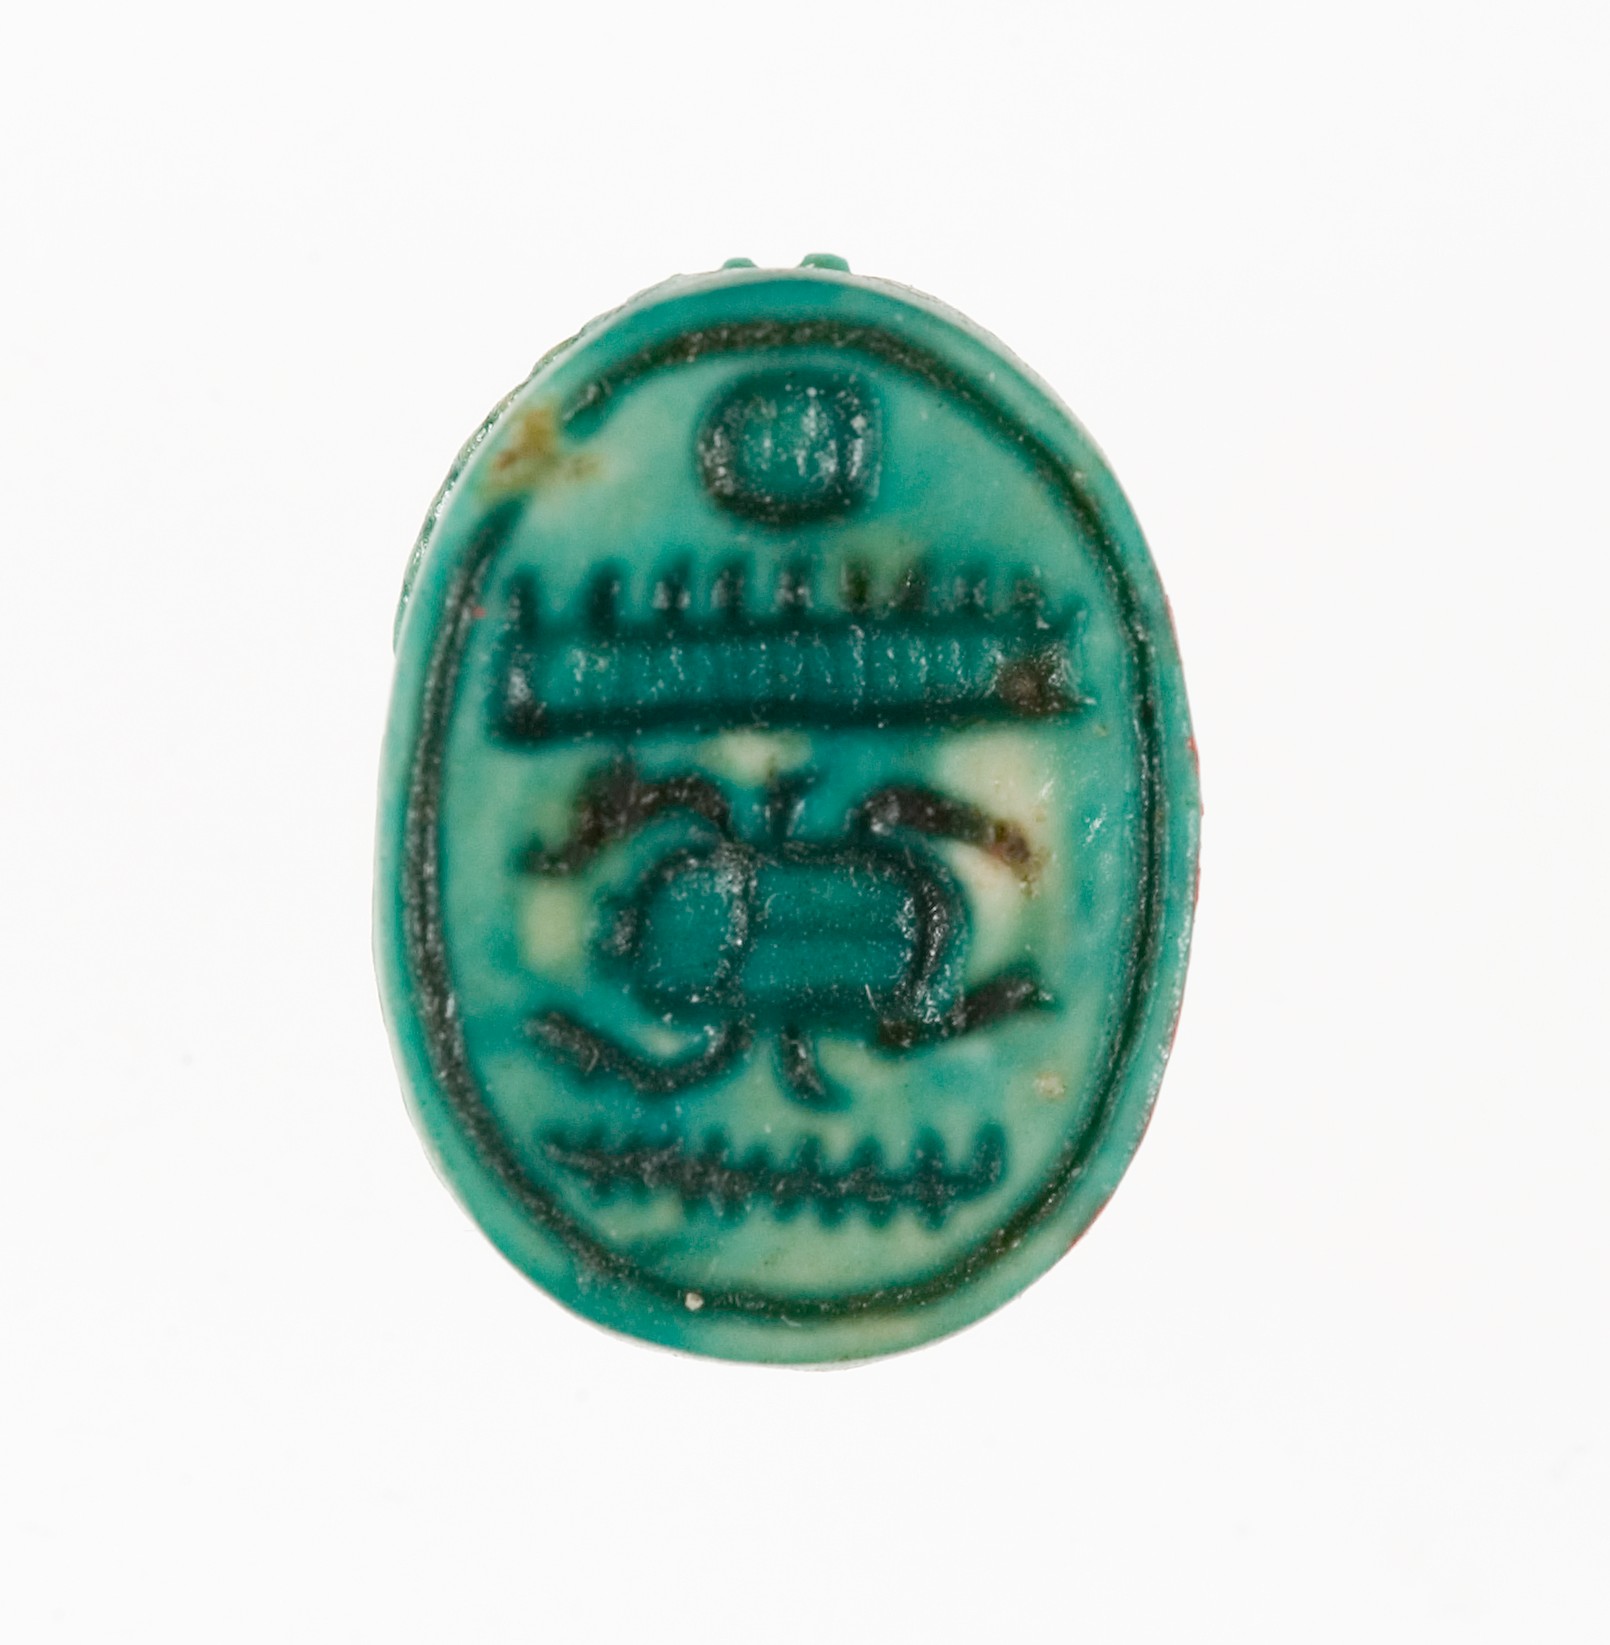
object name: scarab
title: Scarab Inscribed with the Throne Name of Thutmose III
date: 1479-1458 BCE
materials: stone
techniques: glazing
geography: egypt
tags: hieroglyphs,scarabs